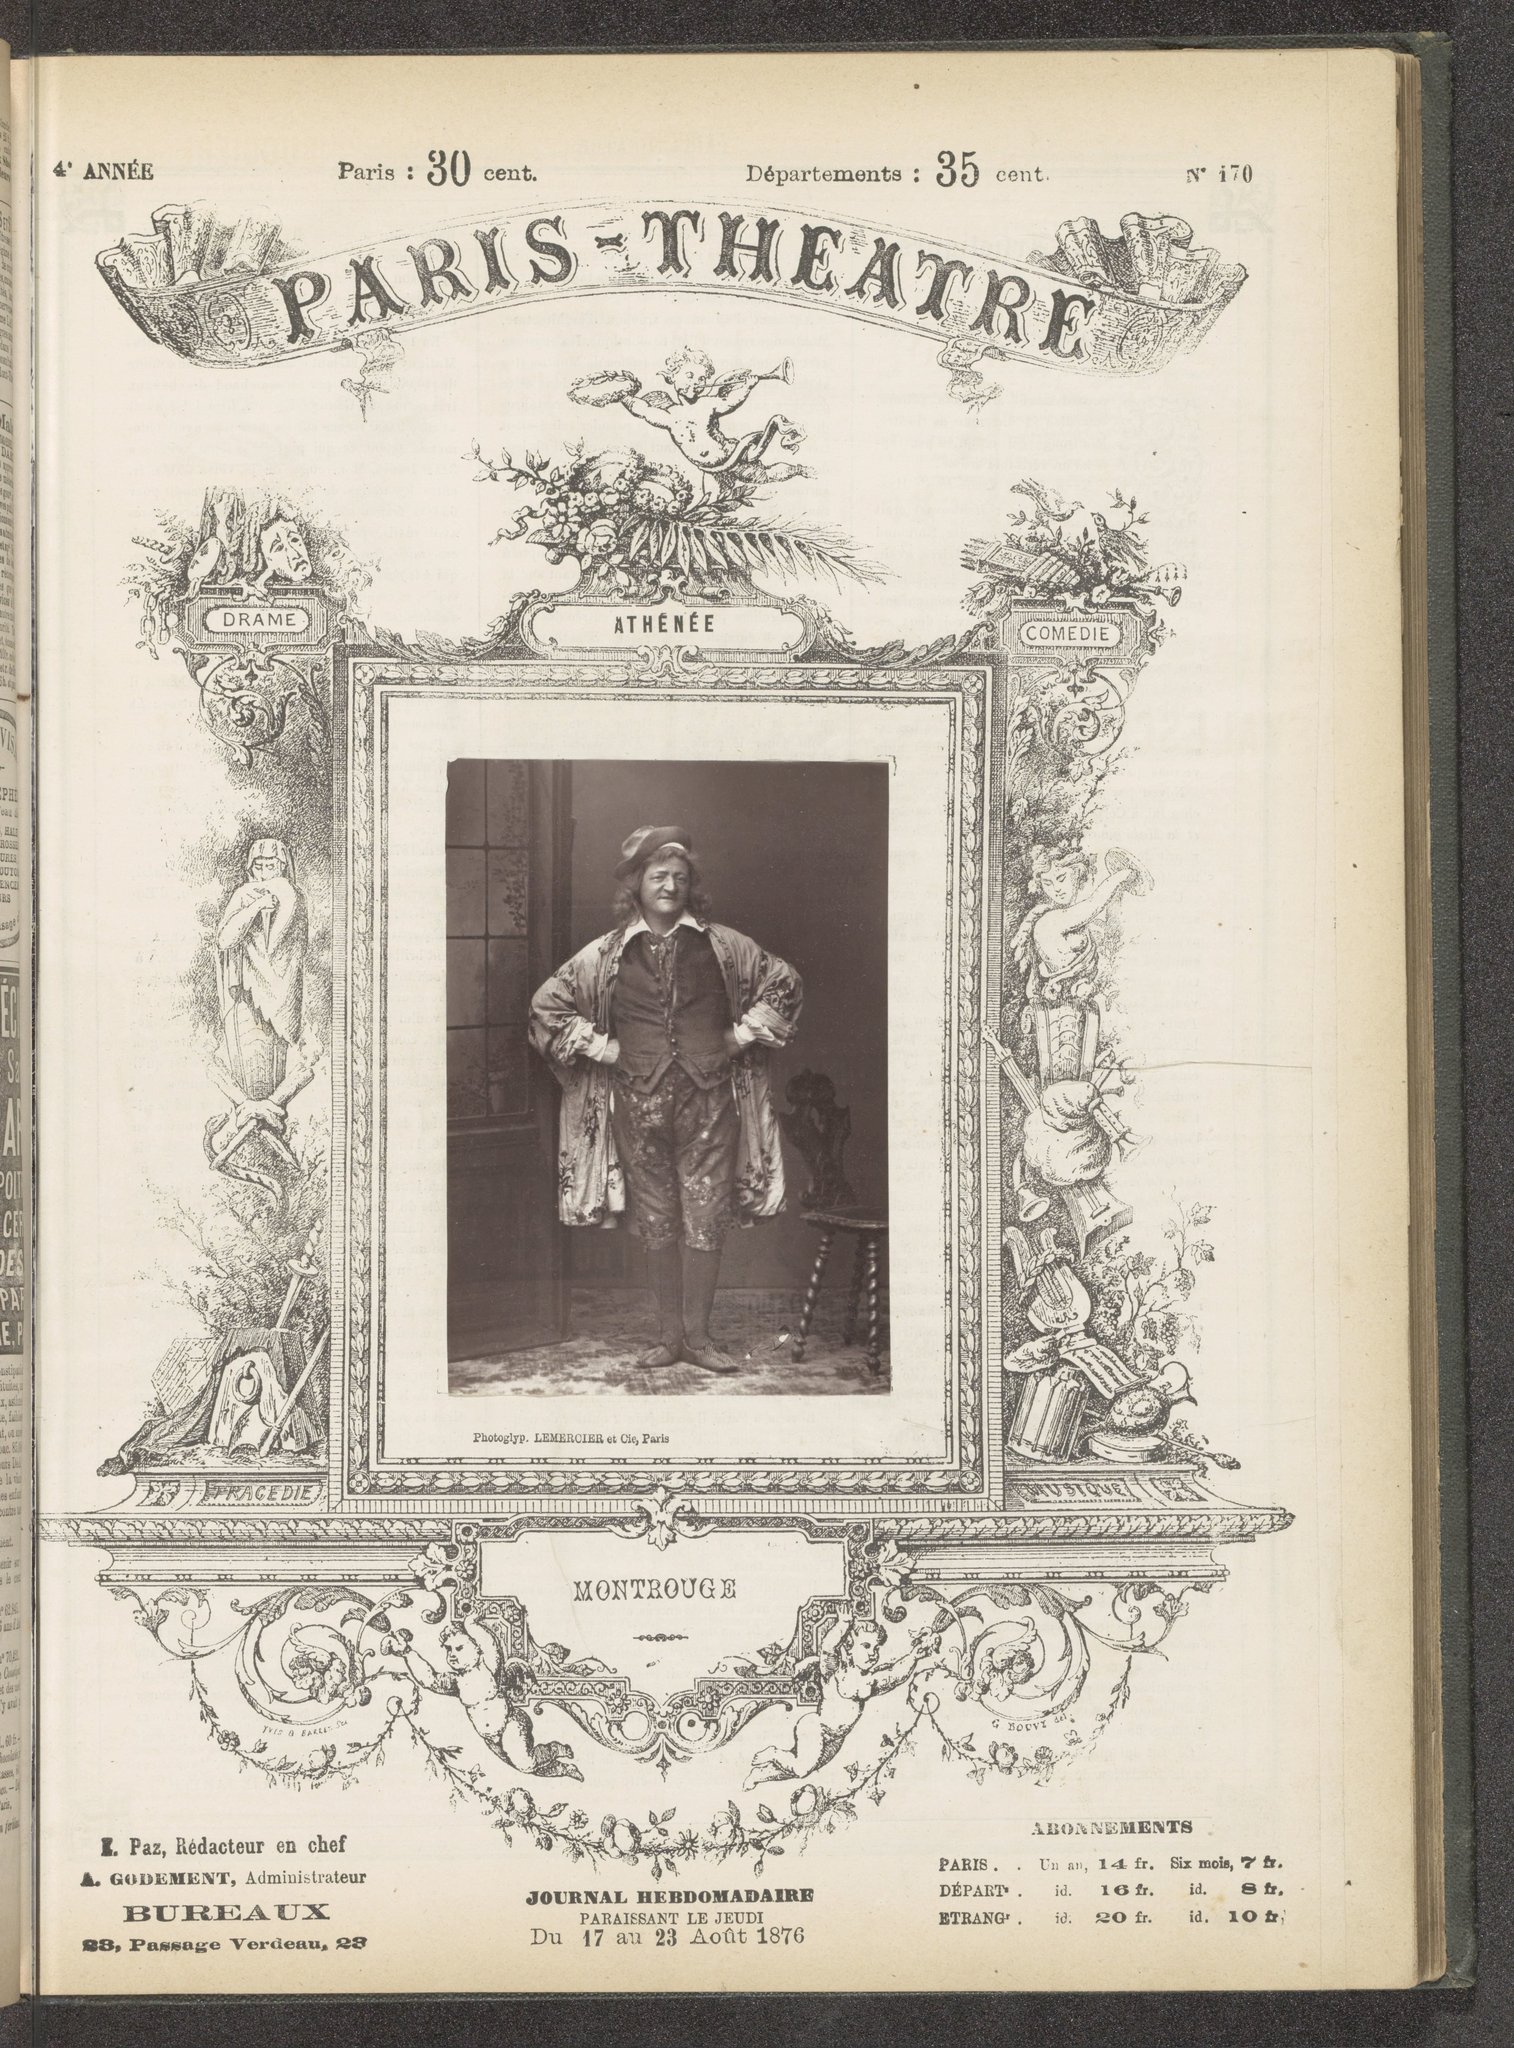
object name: page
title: Portret van Montrouge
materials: paper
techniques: woodburytype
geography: paris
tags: portrait of actor, actress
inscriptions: number: ‘No 170’, inscription: ‘Journal hebdomadaire paraissant le jeudi Du 17 au 23 Août 1876’